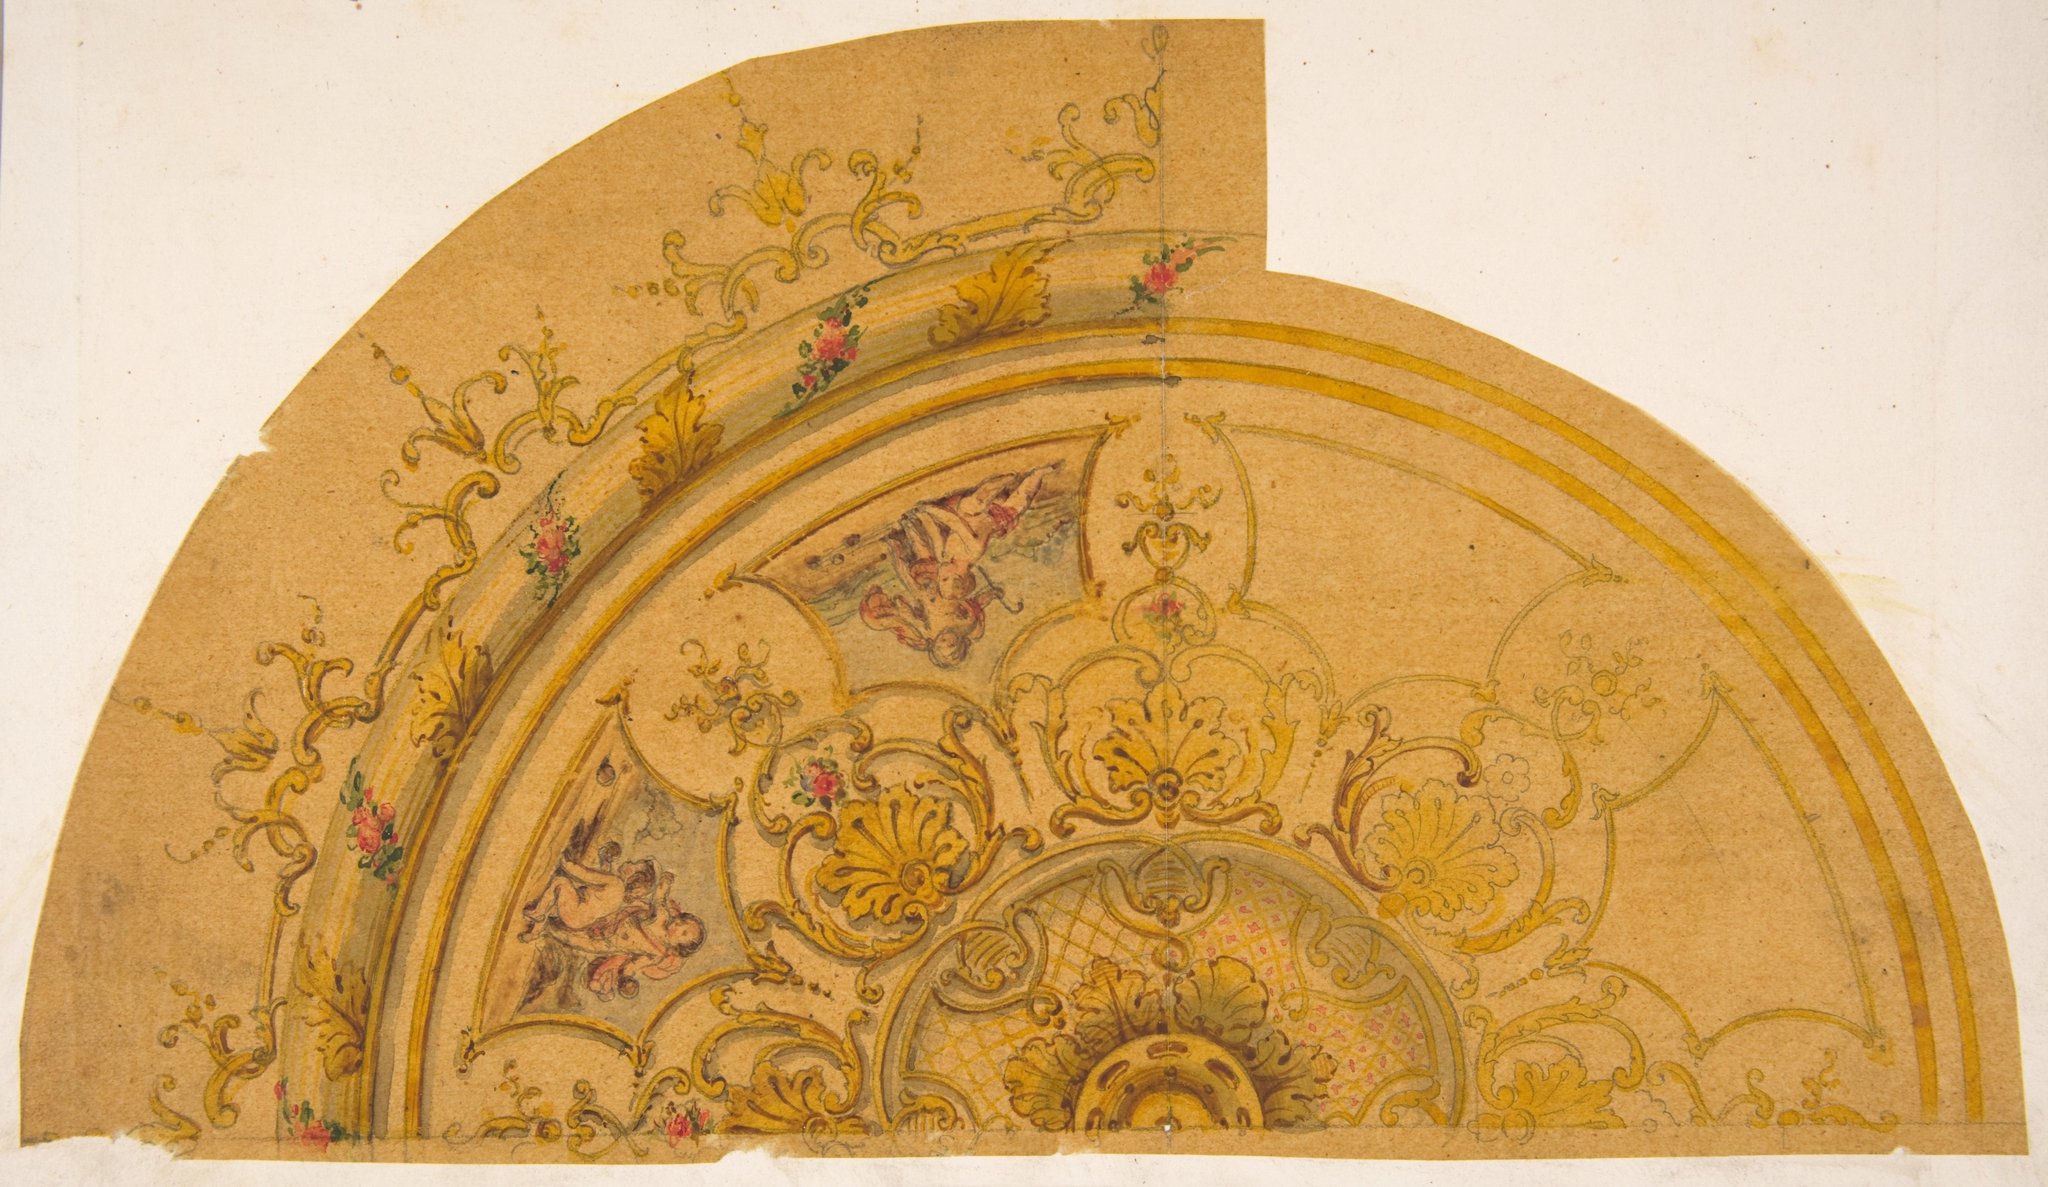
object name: drawing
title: Partial design for a circular ceiling decoration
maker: jules-edmond-charles lachaise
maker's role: artist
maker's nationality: french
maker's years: 1897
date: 1830-1897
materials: cardboard, graphite, paper, watercolor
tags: architecture